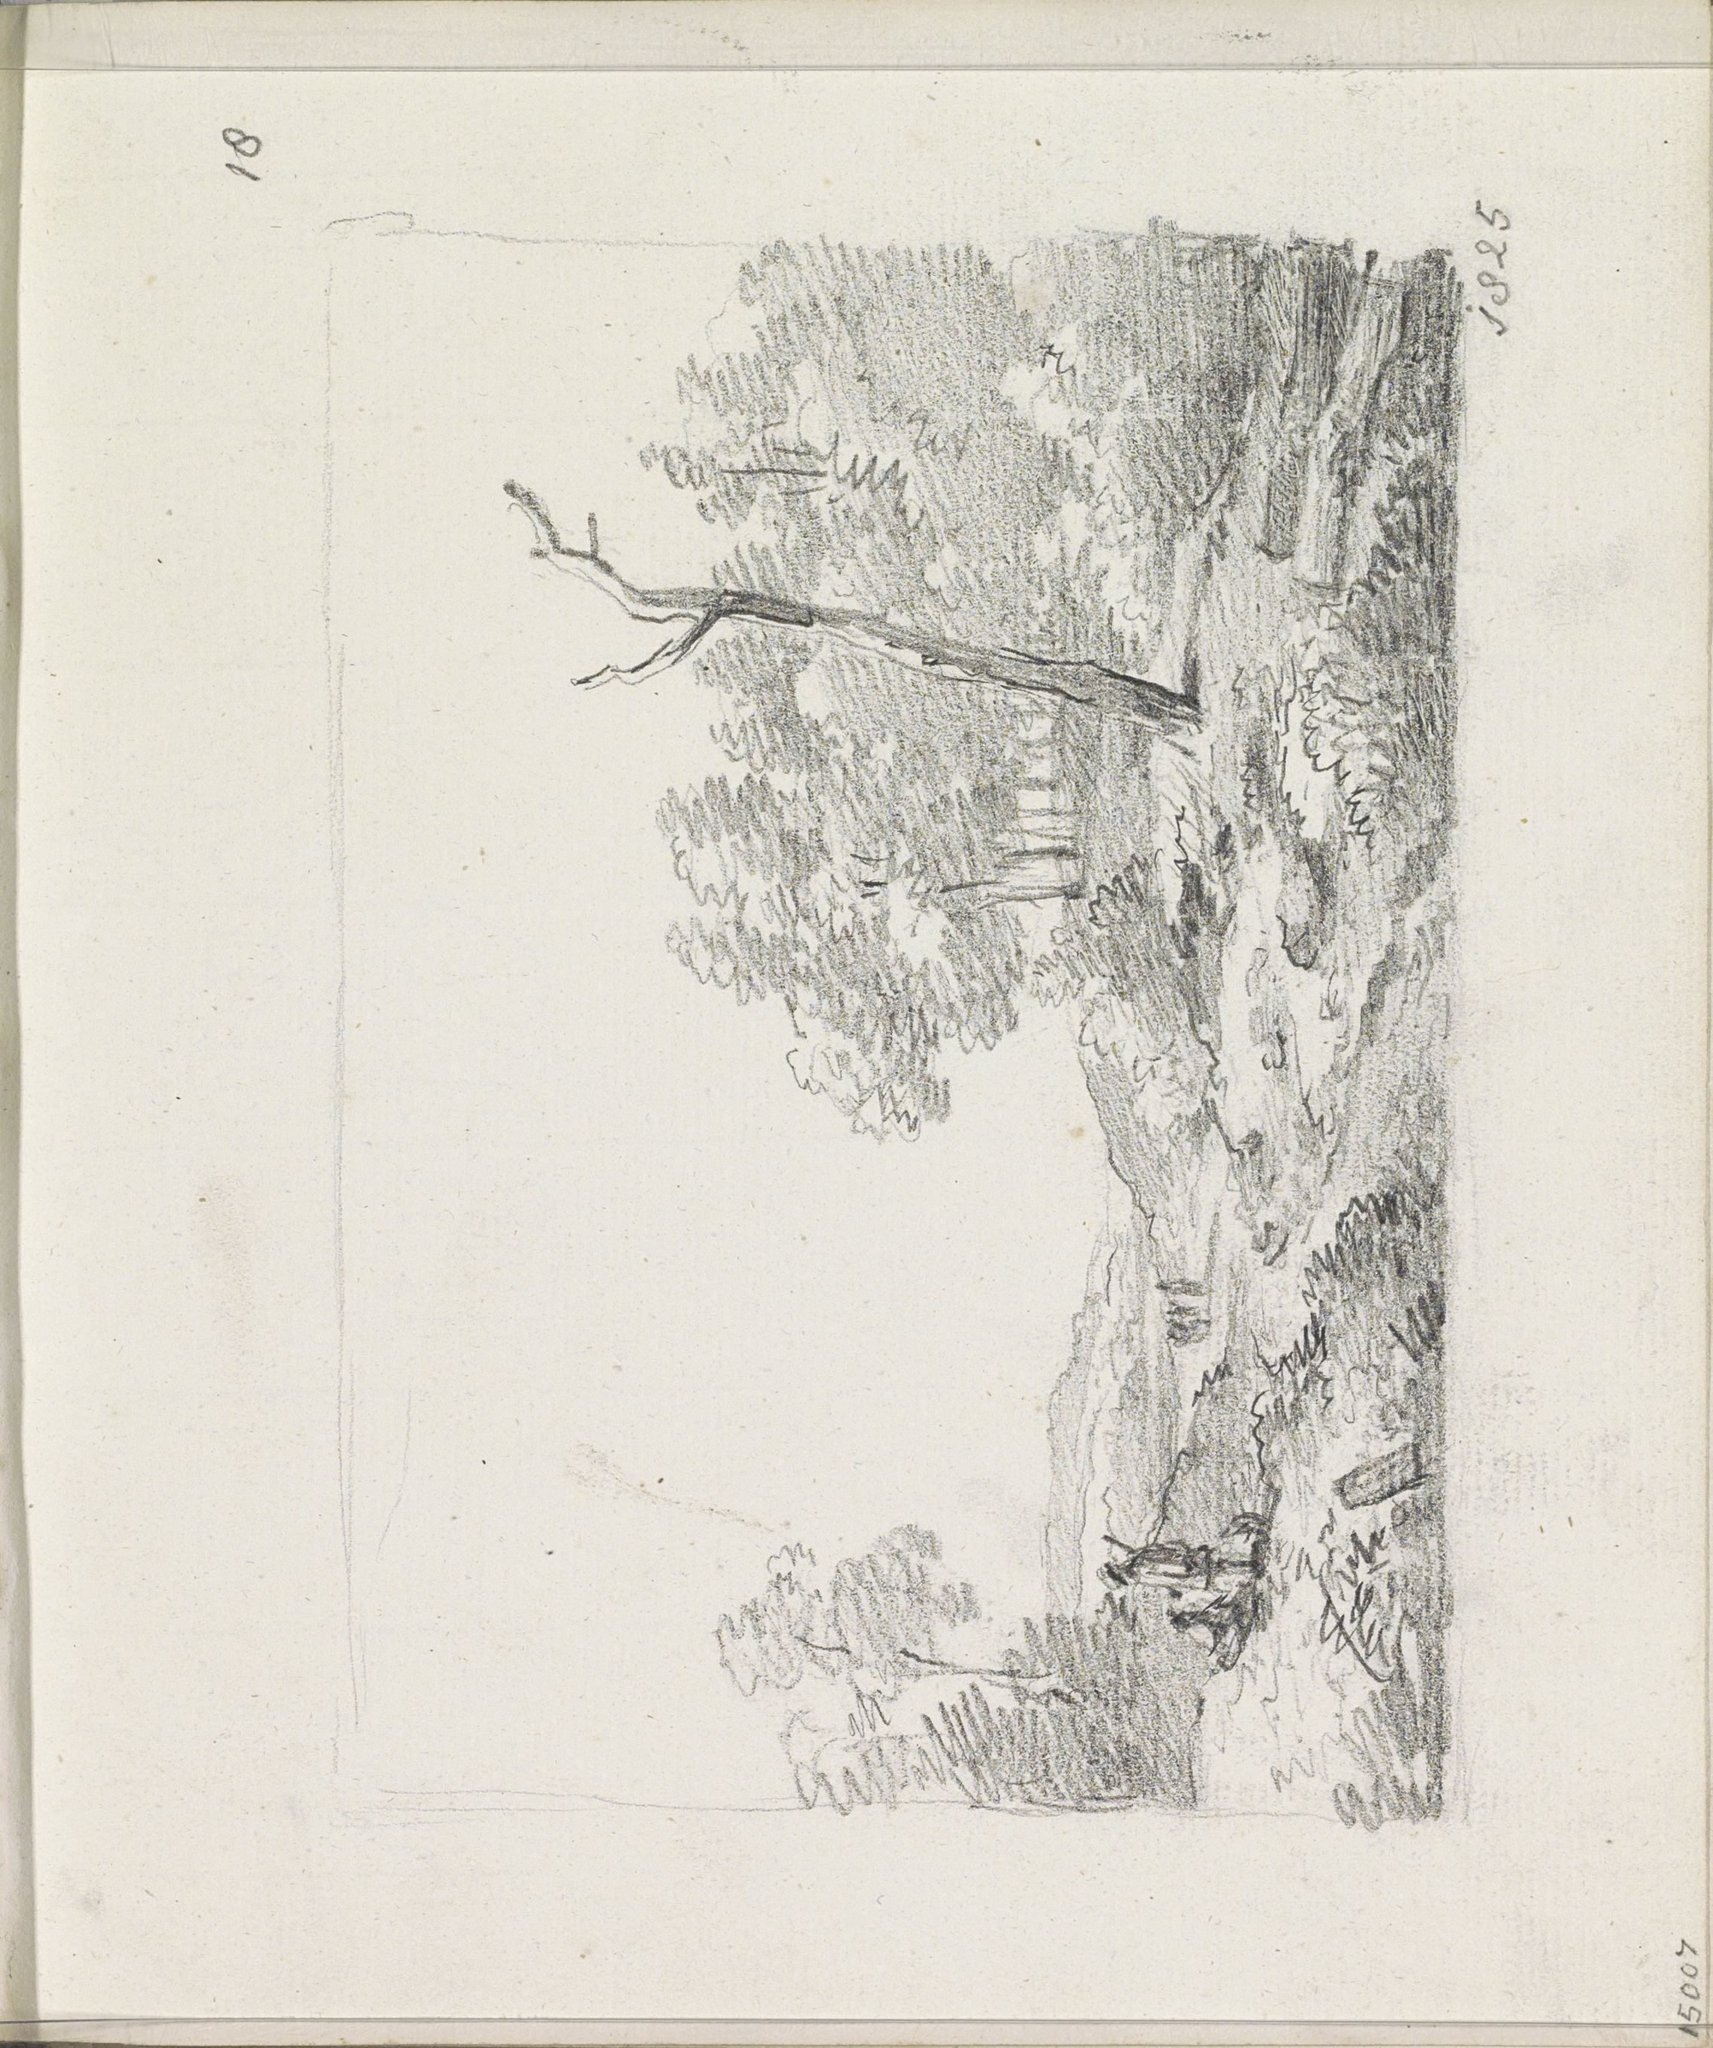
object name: sketchbook leaf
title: Pad door een open landschap met een dode boom en reizigers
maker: andreas schelfhout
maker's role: draughtsman, painter, print maker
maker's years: 1787-1870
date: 1825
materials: paper, pencil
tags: road, path, landscapes (+ landscape with figures, staffage)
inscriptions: number: ‘18/ 15007’, date: ‘1825’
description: Blad 32 recto uit een schetsboek met 95 bladen.